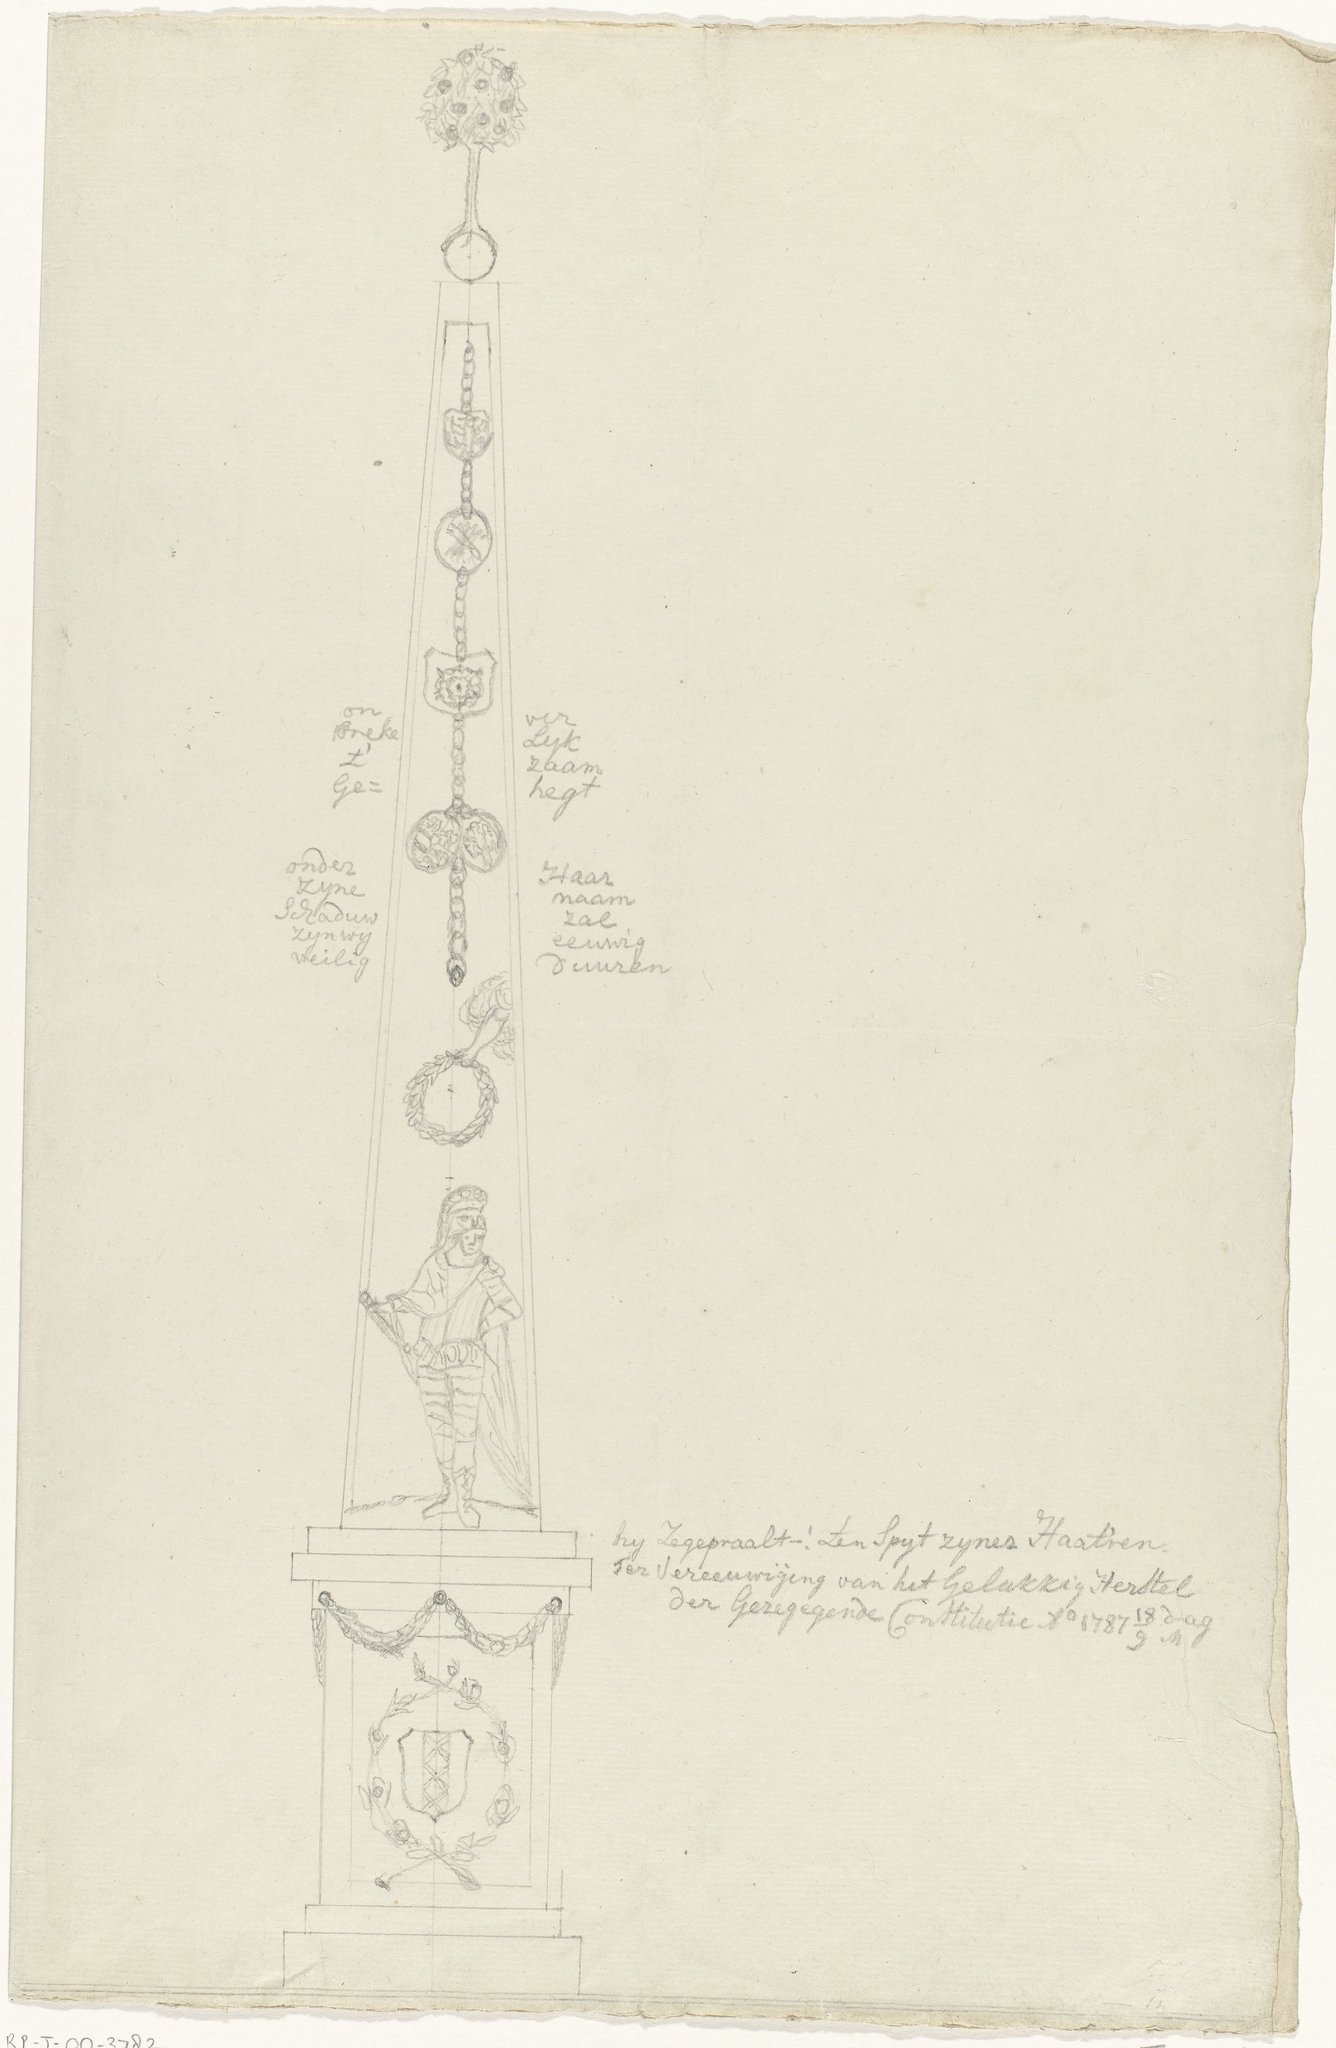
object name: design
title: Ontwerp voor een monument bij het herstel van de oude constitutie te Amsterdam, 1787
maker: Anonymous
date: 1787-1788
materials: paper, pencil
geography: amsterdam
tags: the hague, william v (prince of orange), amsterdam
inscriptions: inscription: ‘hy Zegepraalt -! Ten spyt zynes Haat'ren / Ter vereeuwiging van het Gelukkig Herstel der Gezegegende Constitutie Ao 1787 18/9 dag/m’, collector's mark: Lugt 2228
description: Ontwerp voor een allegorisch monument (of illuminatie?) te Amsterdam. Ter gelegenheid van het herstel van de oude constitutie, dwz de macht van stadhouder Willem V, 18 september 1787. Obelisk bekroond met een Oranjeboom en versierd met wapens en vignetten. Onderaan een krijger (de stadhouder?) staande op een voetstuk met het stadswapen van Amsterdam. Schets op de voorzijde van een dubbelgevouwen blad.